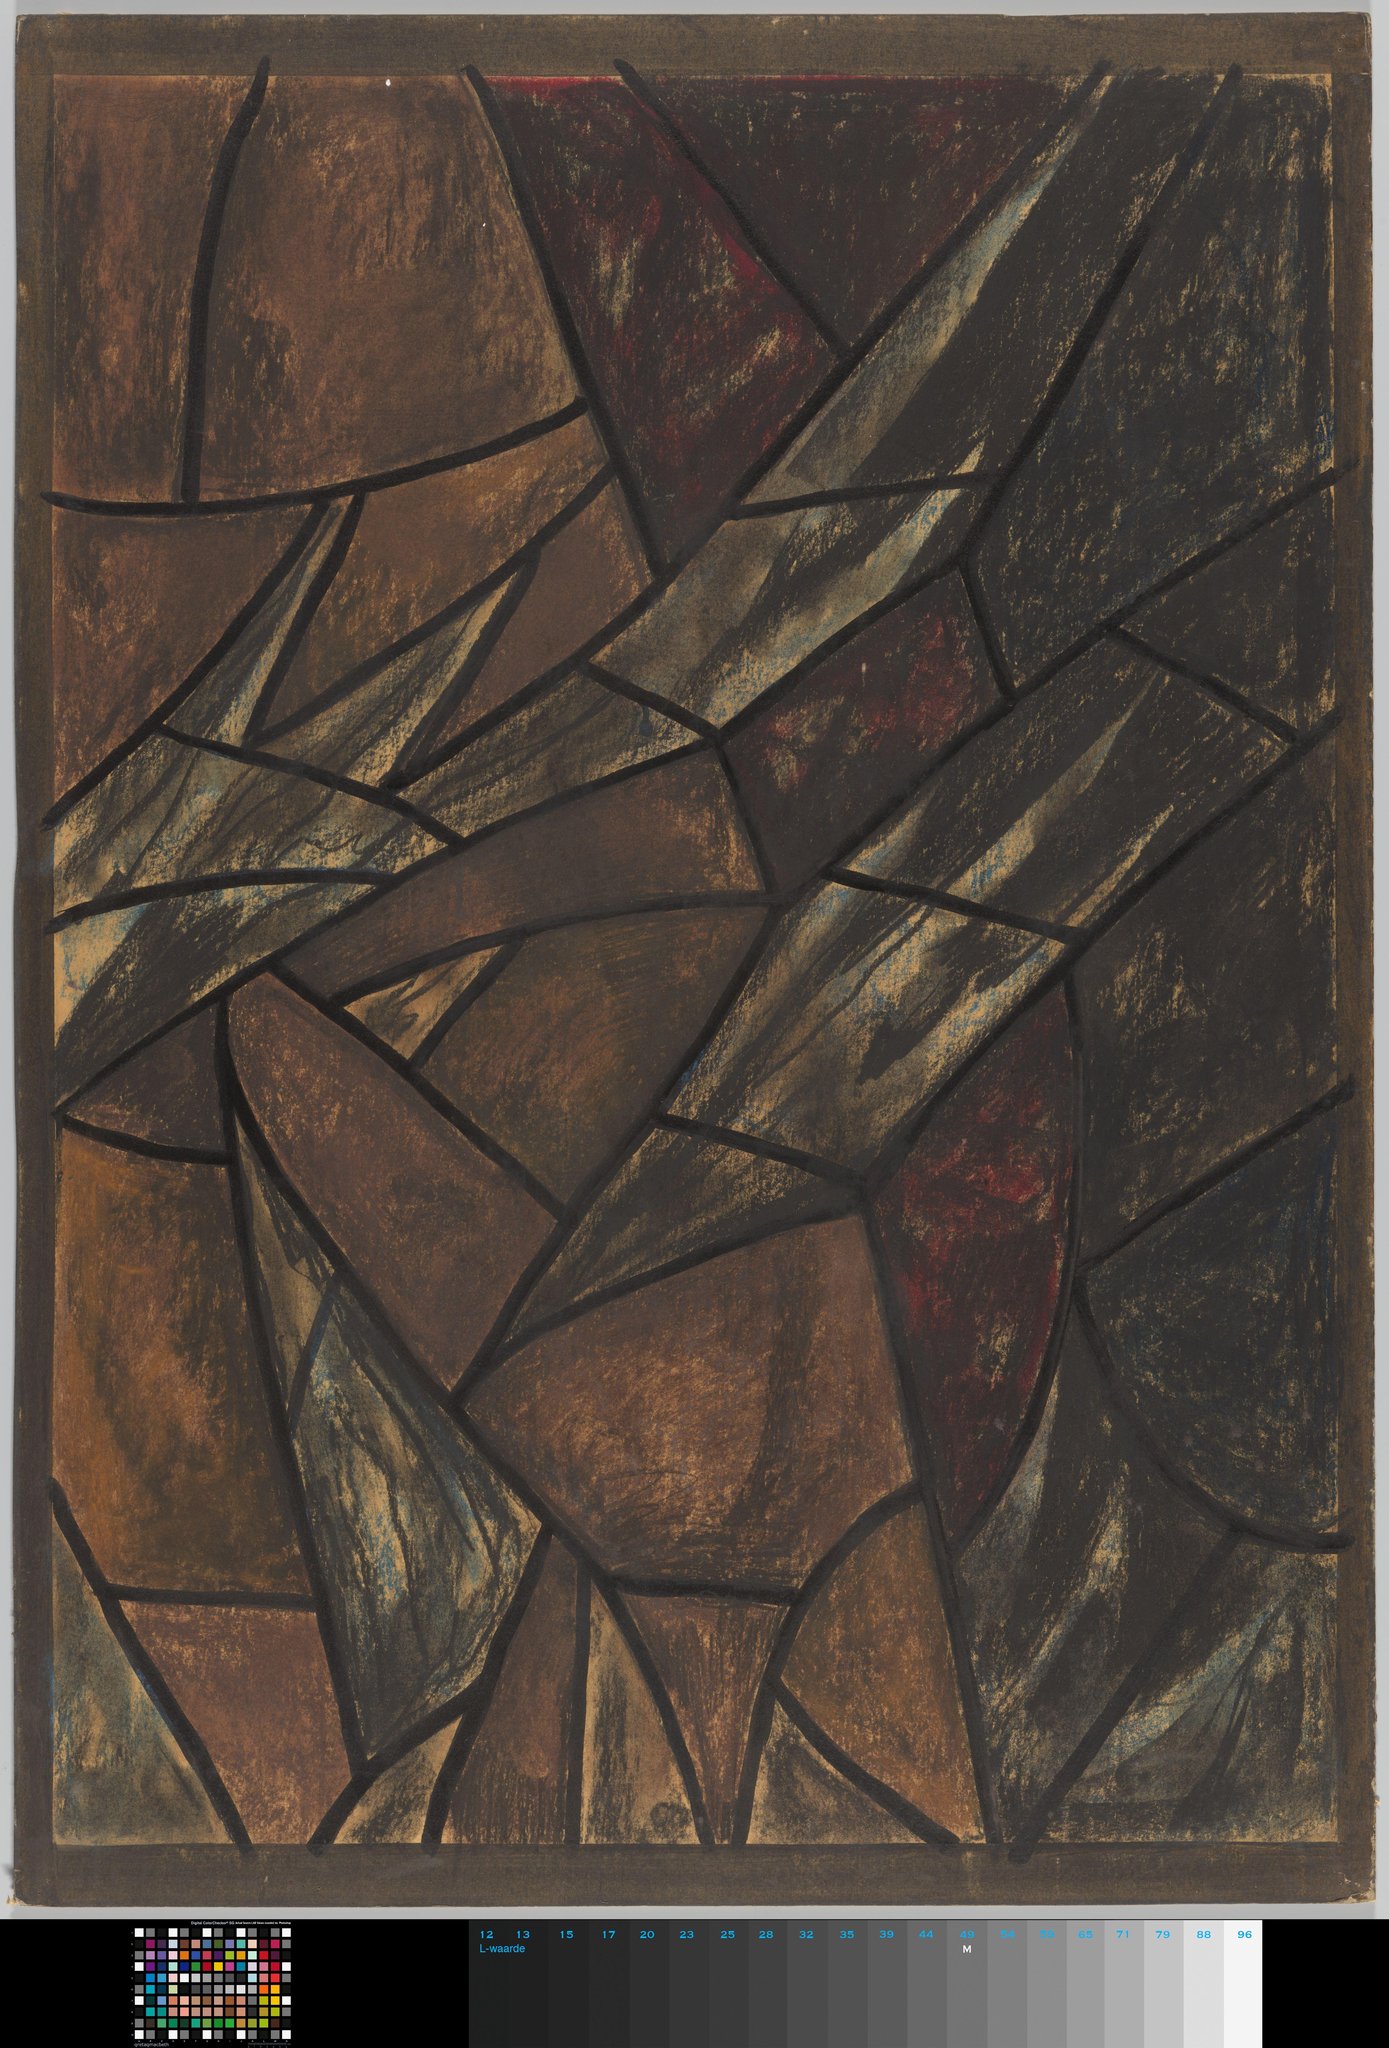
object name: drawing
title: Ontwerp voor raam in het Noordertransept in de Dom te Utrecht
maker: richard nicolaüs roland holst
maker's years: 1868-1938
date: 1934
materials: cardboard, chalk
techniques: brush